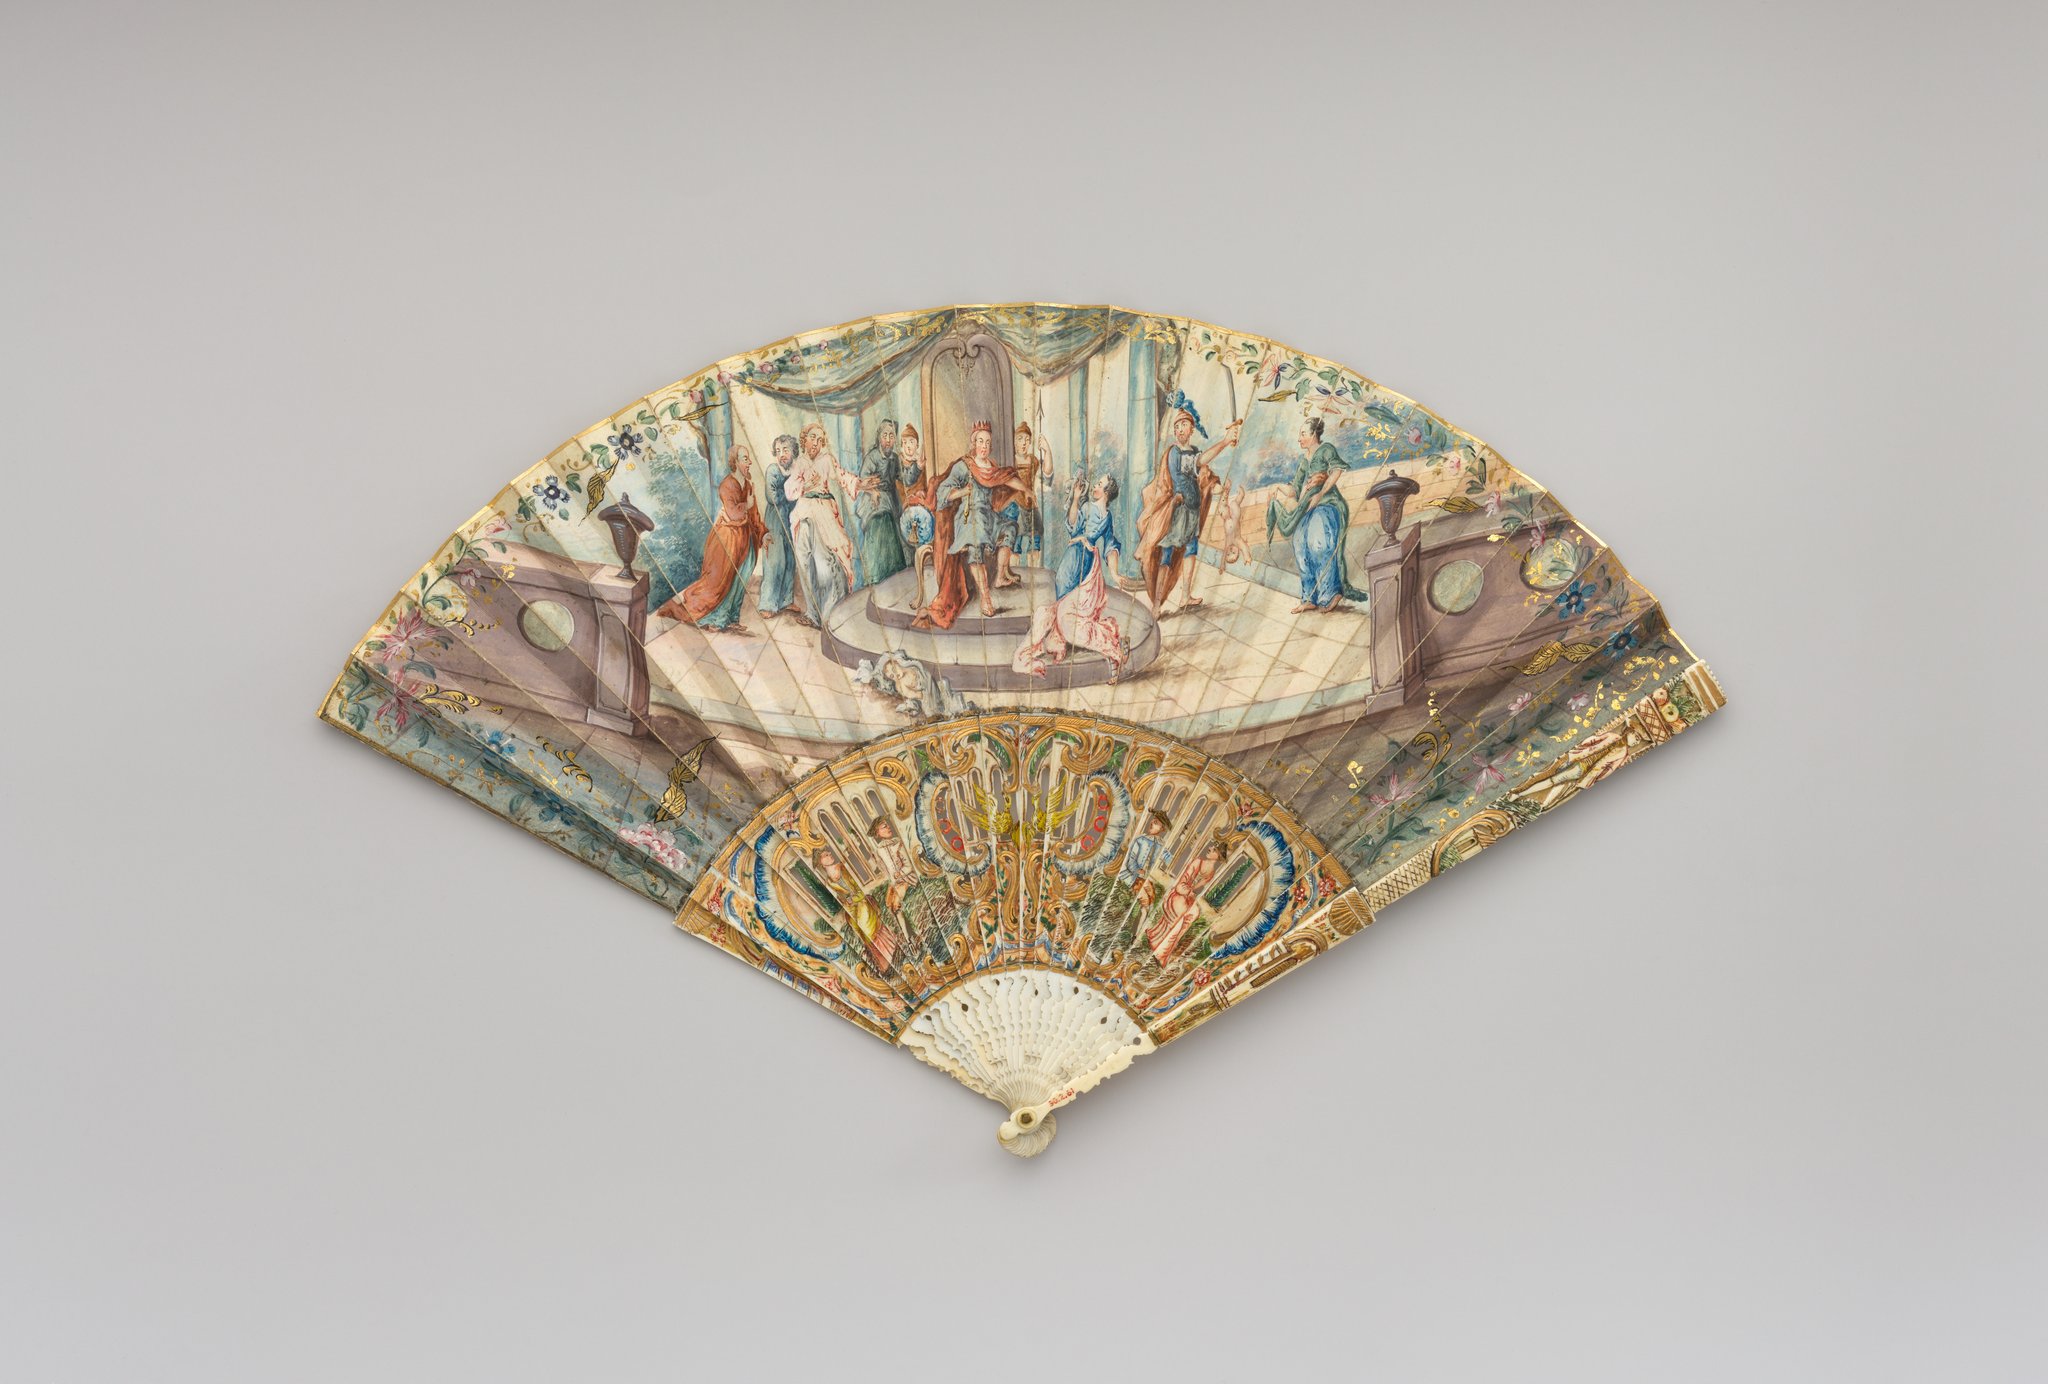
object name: fan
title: The Judgement of Solomon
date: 1751-1775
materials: gilt, ivory, paint, paper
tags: infants,men,women